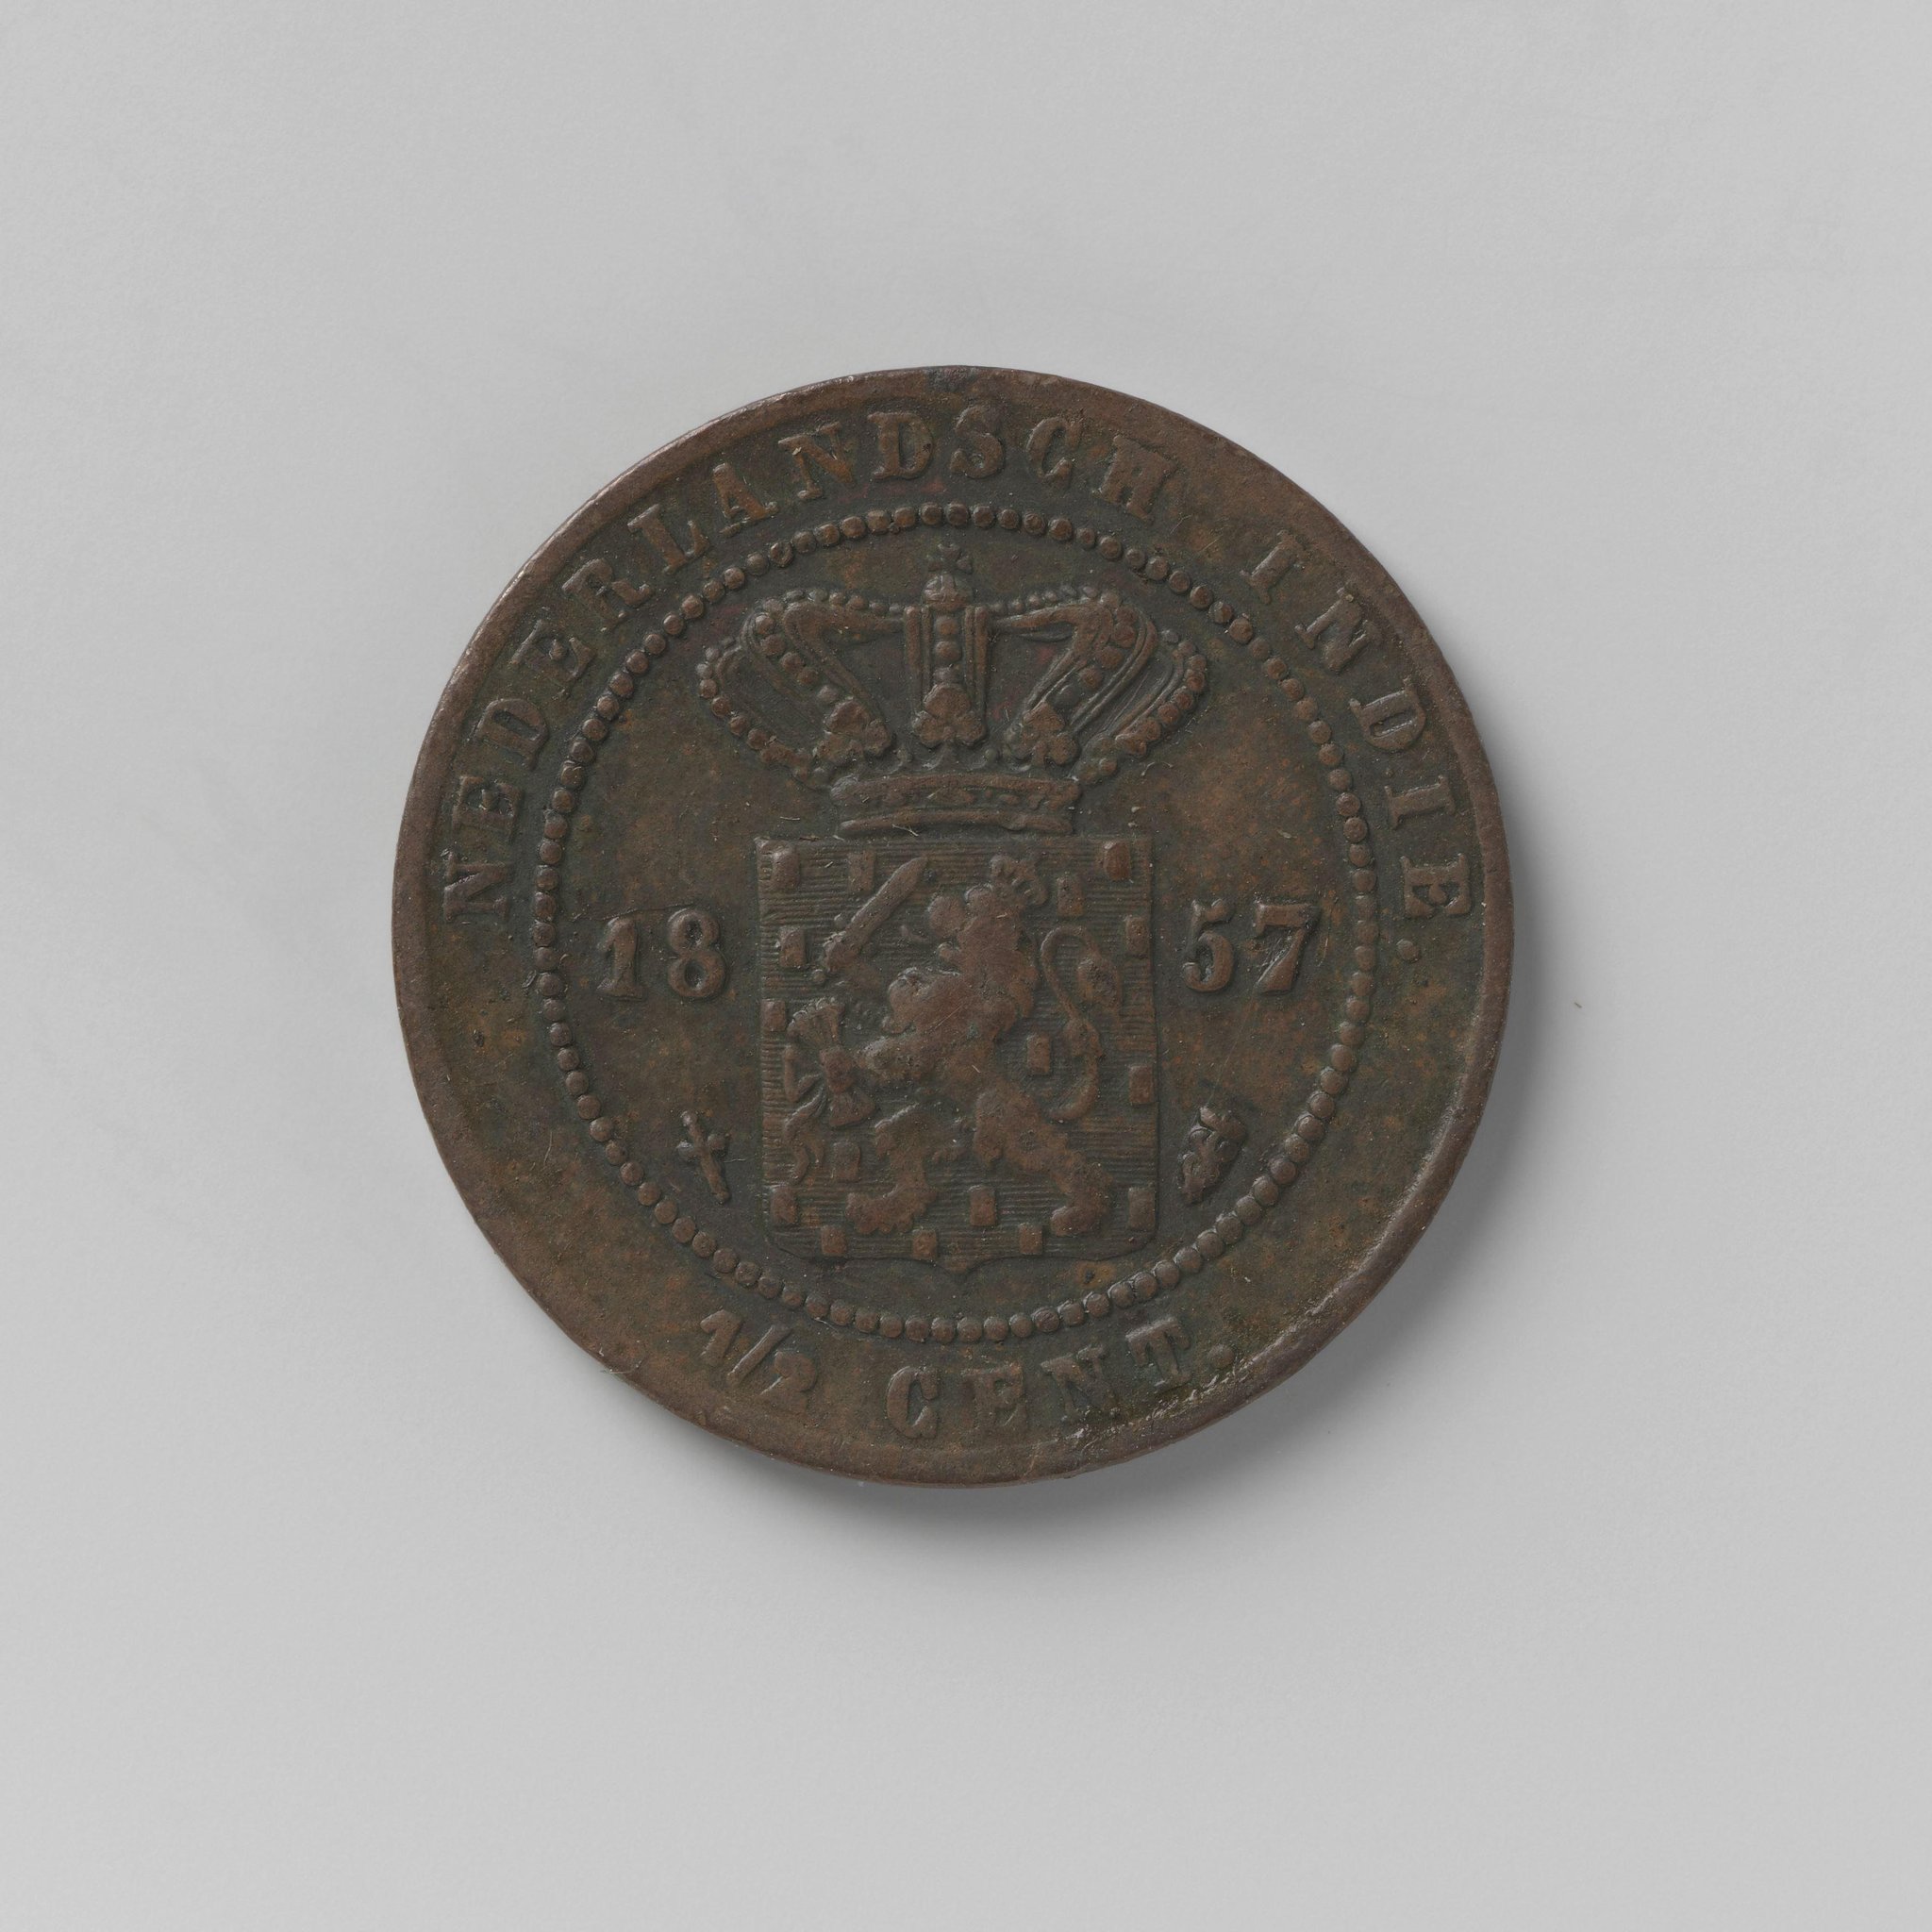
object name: coin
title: ½ cent van Nederlands Indië, 1857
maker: willem iii (koning der nederlanden)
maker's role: koning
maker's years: 1817-1890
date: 1857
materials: copper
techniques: striking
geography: utrecht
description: Koperen munt. Voorzijde: tussen jaartal gekroond rijkswapenschild. Boven kroon landsaanduiding en onder wapenschild waarde-aanduiding. Keerzijde: drieregelig Maleis opschrift in Arabische tekens, waaromheen omschrift in het Javaans. Gladde rand.